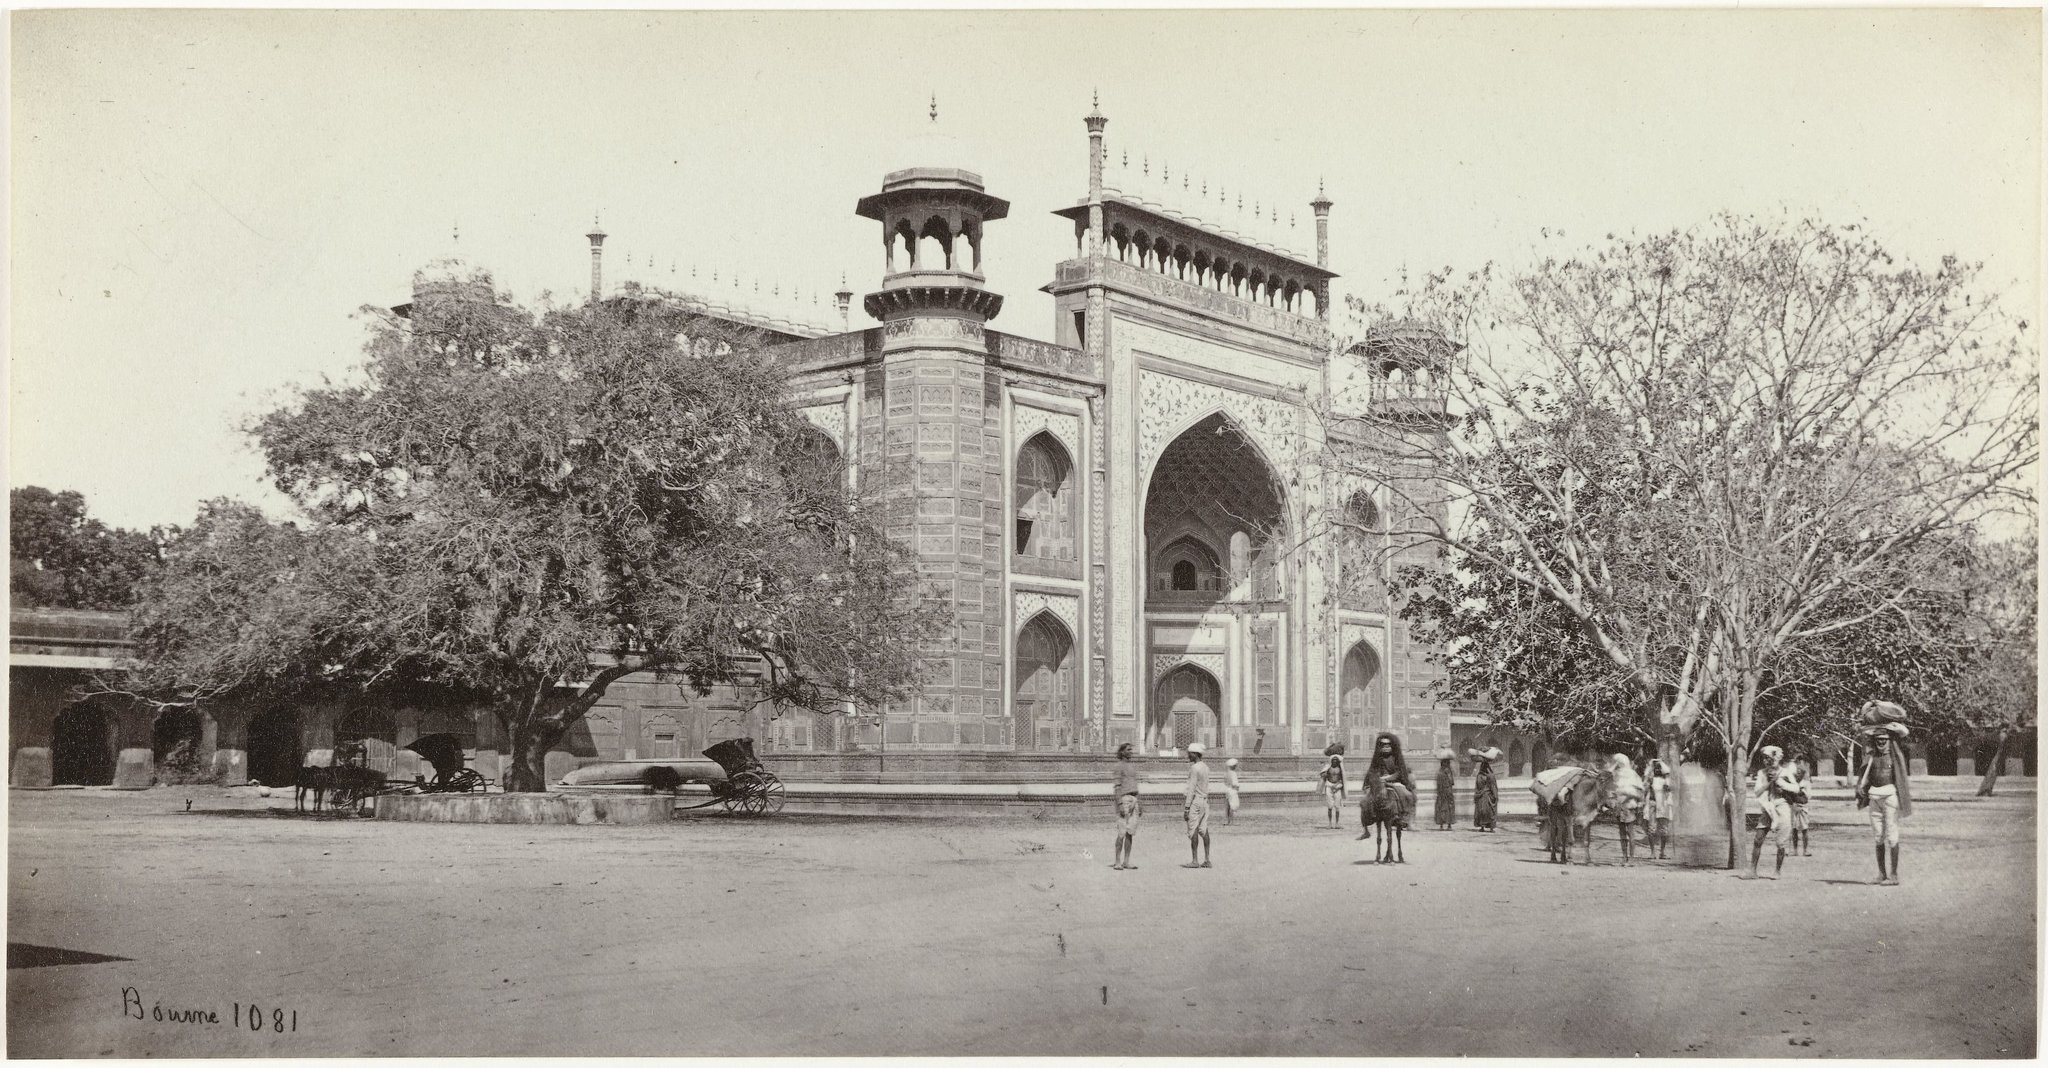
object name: photograph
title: Darwaza-i-rauza, entrance gate of the Taj Mahal, Agra, India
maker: samuel bourne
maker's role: fotograaf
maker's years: 1834-1912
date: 1864-1870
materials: paper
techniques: albumen print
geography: taj mahal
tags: gate, entrance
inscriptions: inscription: ‘Gate of the Taj/ Agra’, number: ‘1081’, number: ‘1081’, name: ‘Bourne’